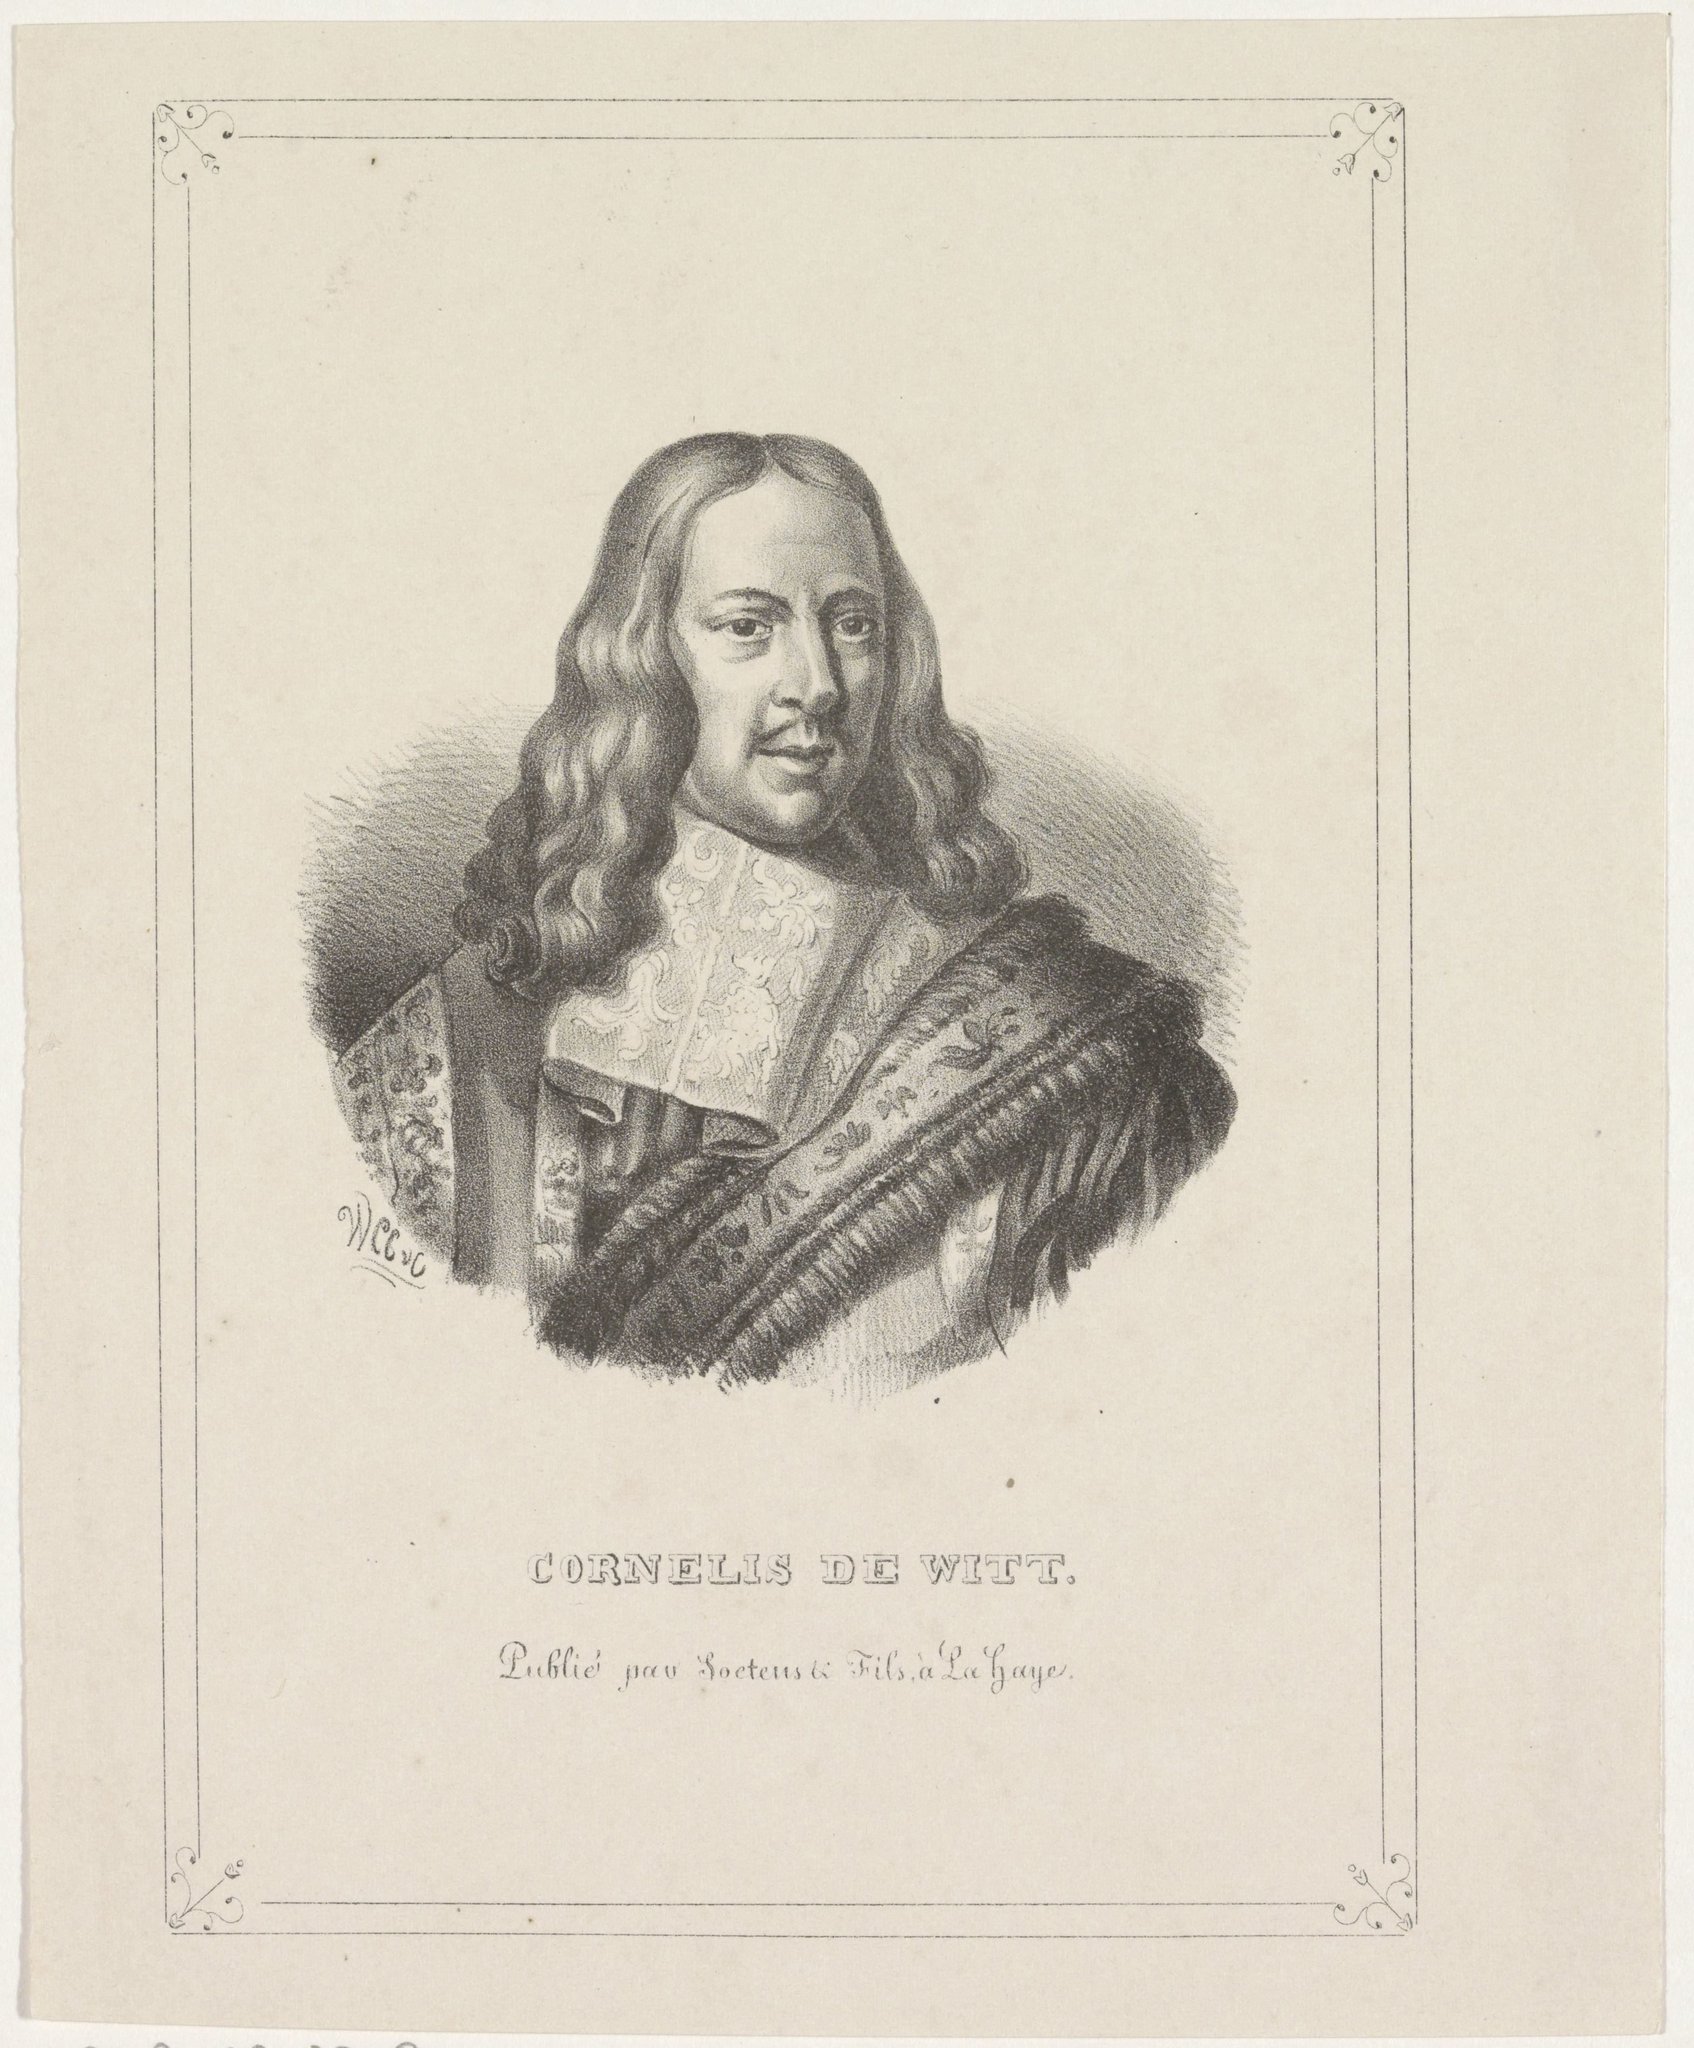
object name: print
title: Portret van Cornelis de Witt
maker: wilhelmus cornelis chimaer van oudendorp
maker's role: print maker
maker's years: 1822-1873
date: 1837-1840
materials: paper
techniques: lithograph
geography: netherlands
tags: dordrecht, the hague, cornelis de witt, historical persons (+ (full) bust portrait)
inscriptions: collector's mark: Lugt 2228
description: De geportretteerde draagt een mantel met bloemmotieven, bont en franjes of veren. Zijn haar hangt tot op zijn schouders en hij draagt een grote witte bef of kraag met bloemmotieven.